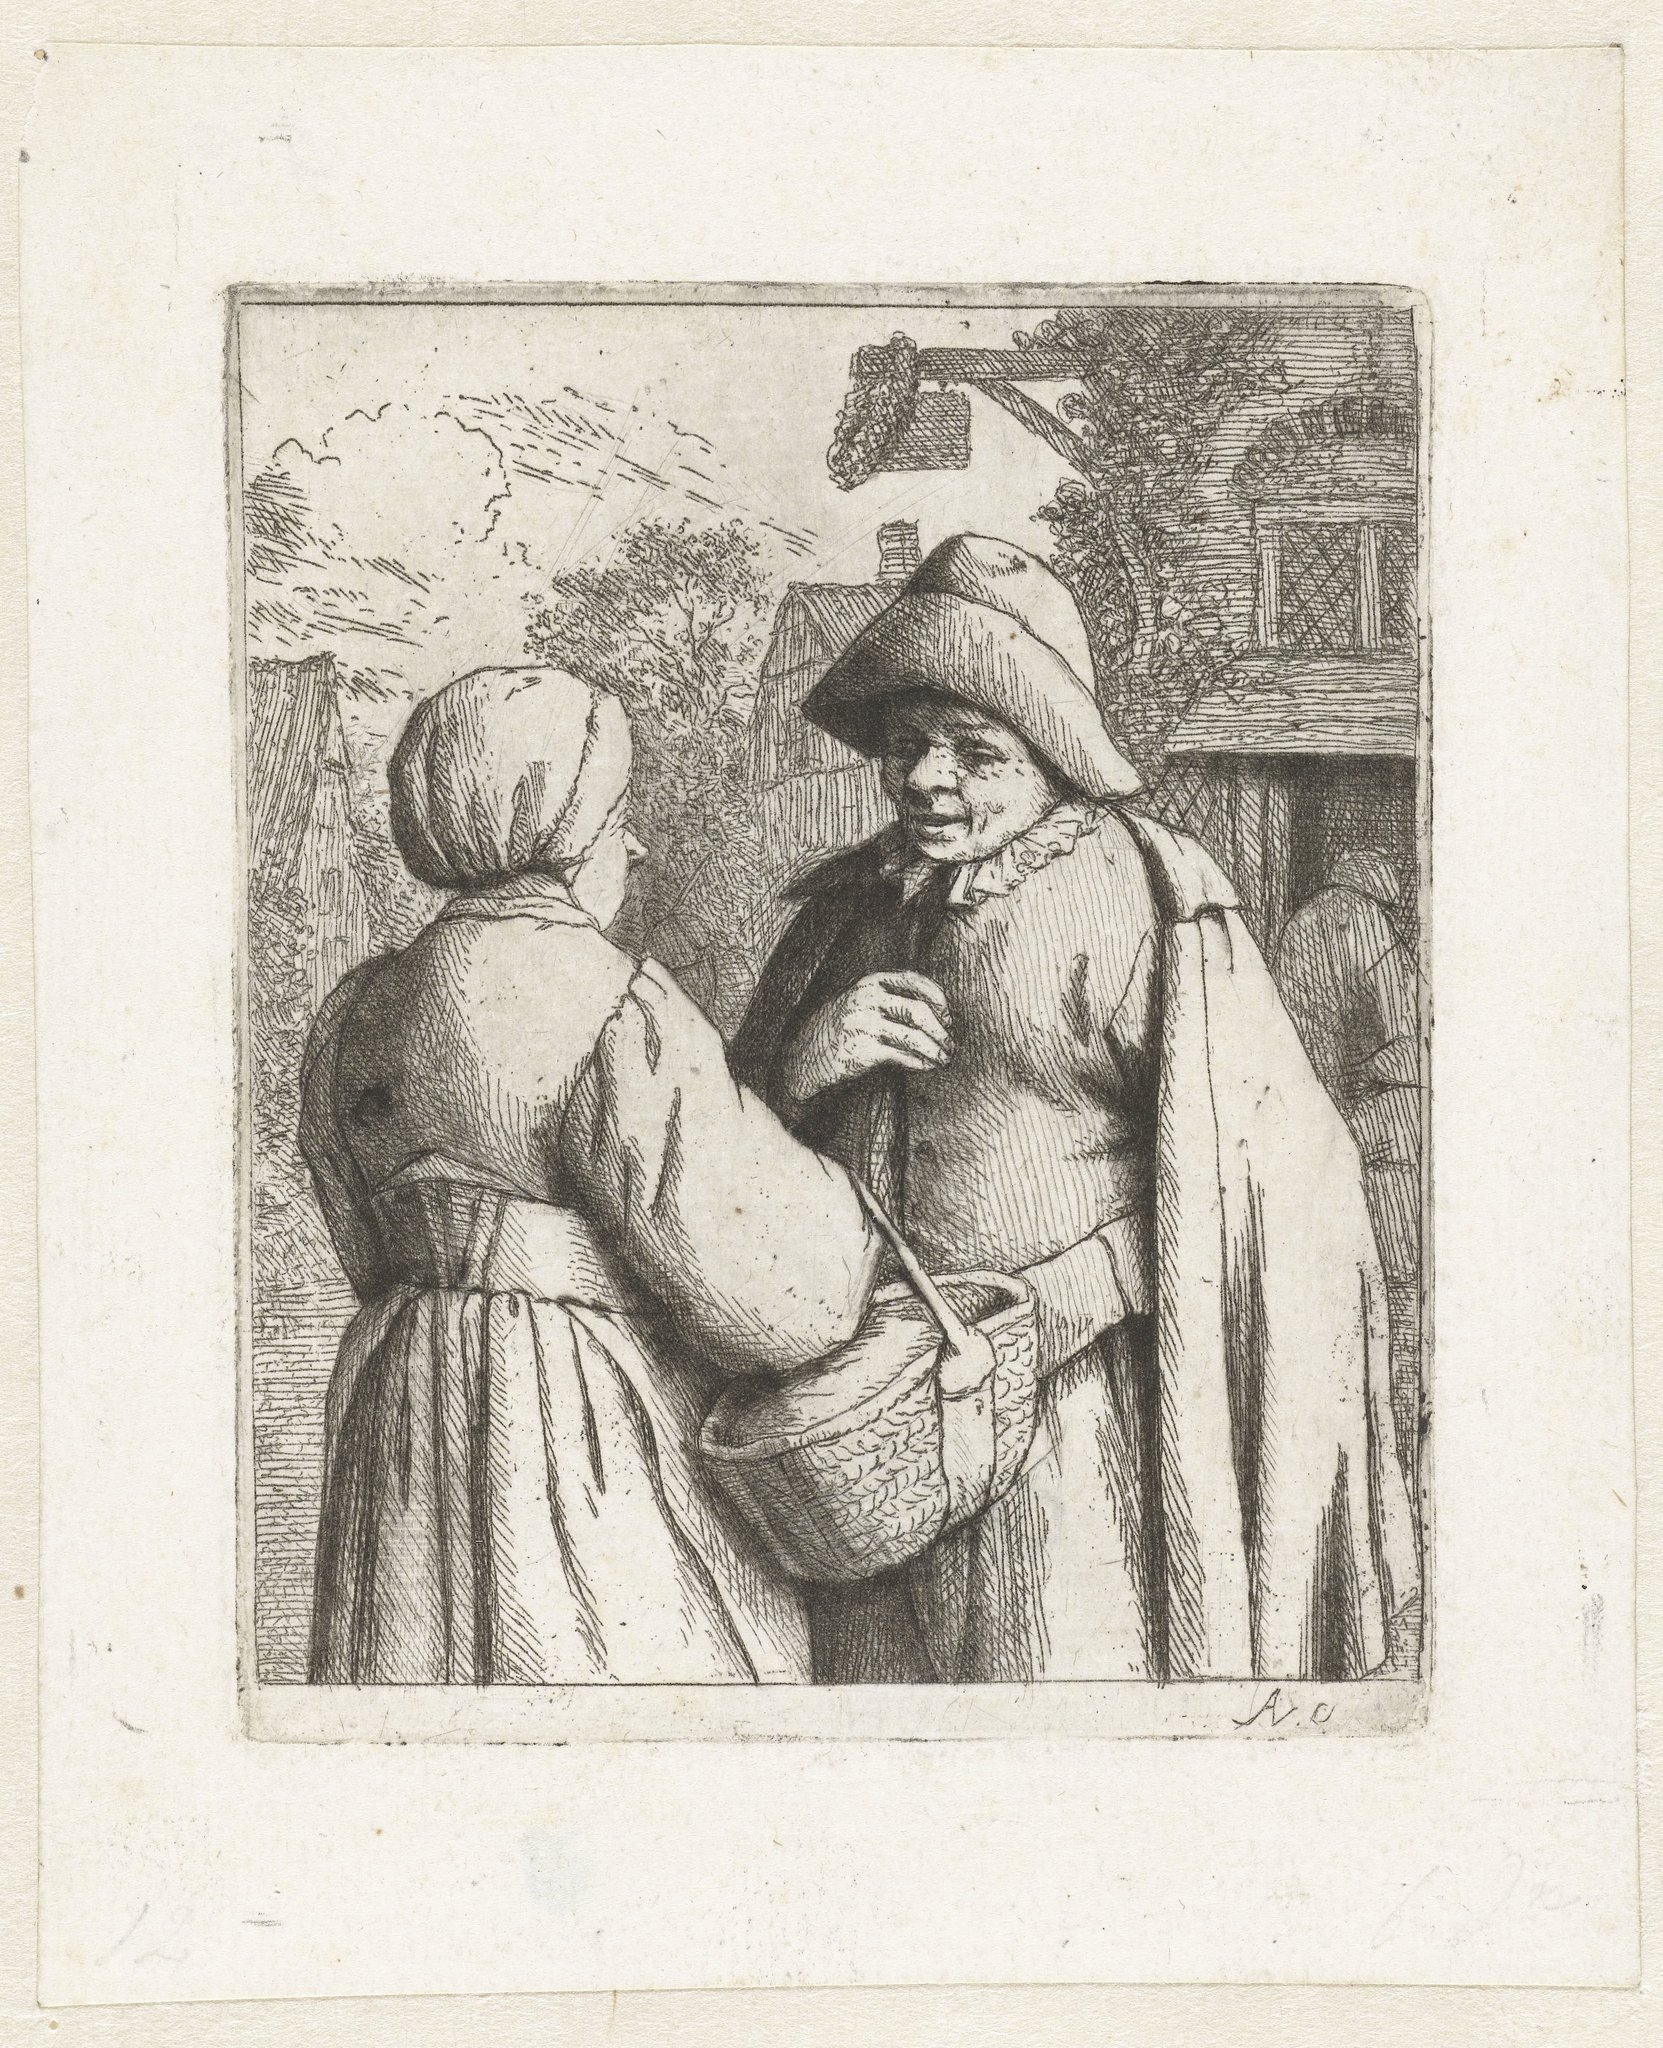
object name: print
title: Vrouw en man met elkaar in gesprek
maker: adriaen van ostade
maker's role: draughtsman, painter, print maker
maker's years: 1610-1685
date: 1668-1678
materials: paper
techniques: etching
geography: haarlem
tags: speaking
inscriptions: collector's mark: Lugt 2228, collector's mark: Lugt 2760